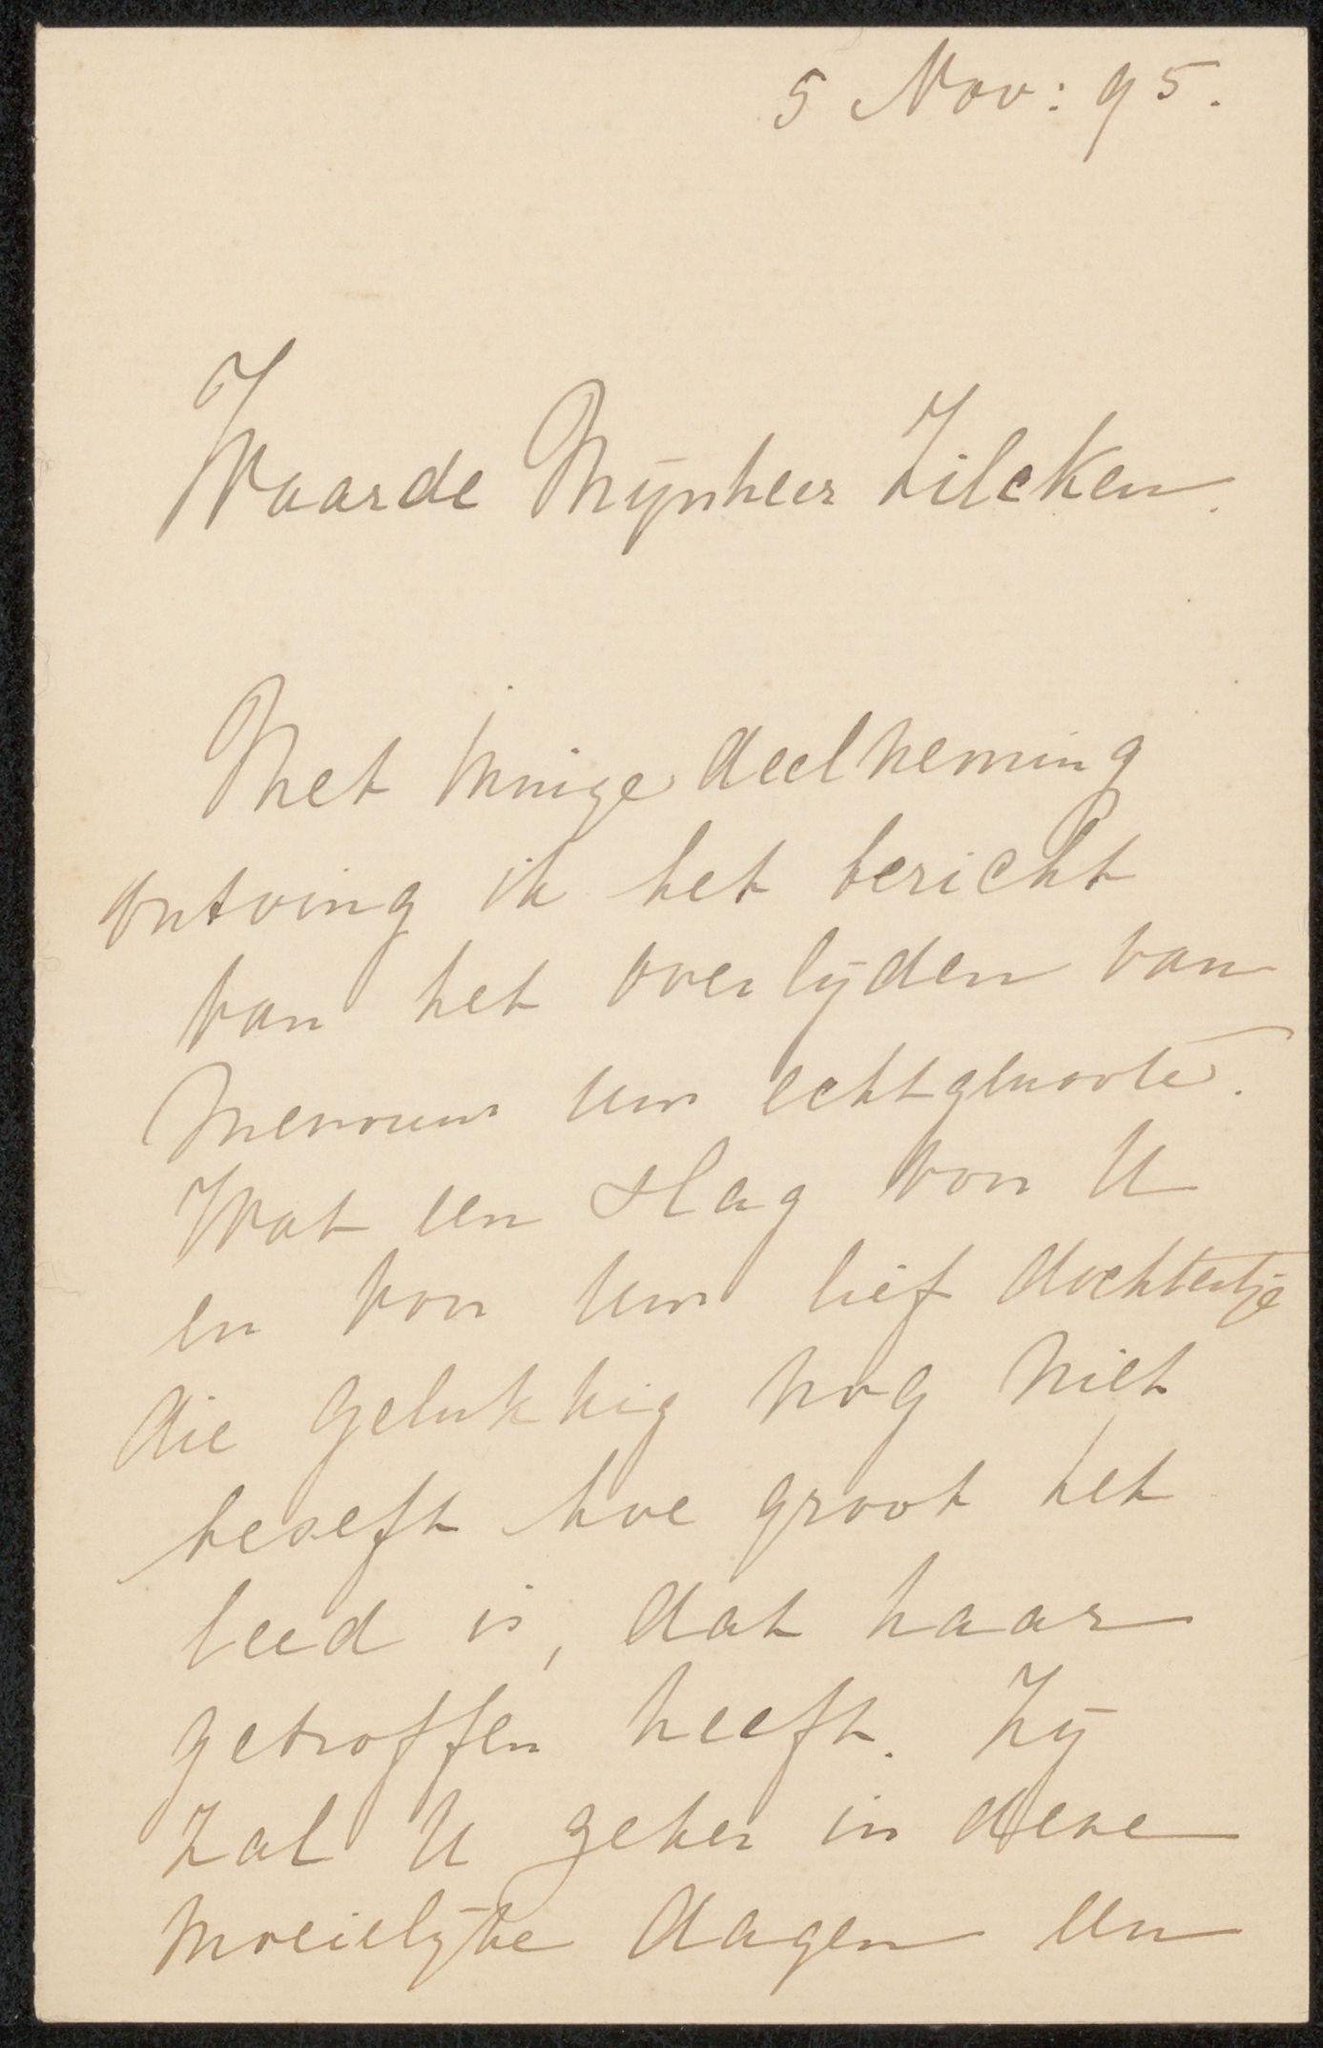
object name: postcard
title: Briefkaart aan Philip Zilcken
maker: amy bridge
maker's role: designer, draughtsman, painter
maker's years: 1867-1930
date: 1895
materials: ink, paper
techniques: pen, writing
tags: renée hélène laure zilcken, helène lambertine hauzeur, the hague, painter, draughtsman, philip zilcken, passions, emotions, affections